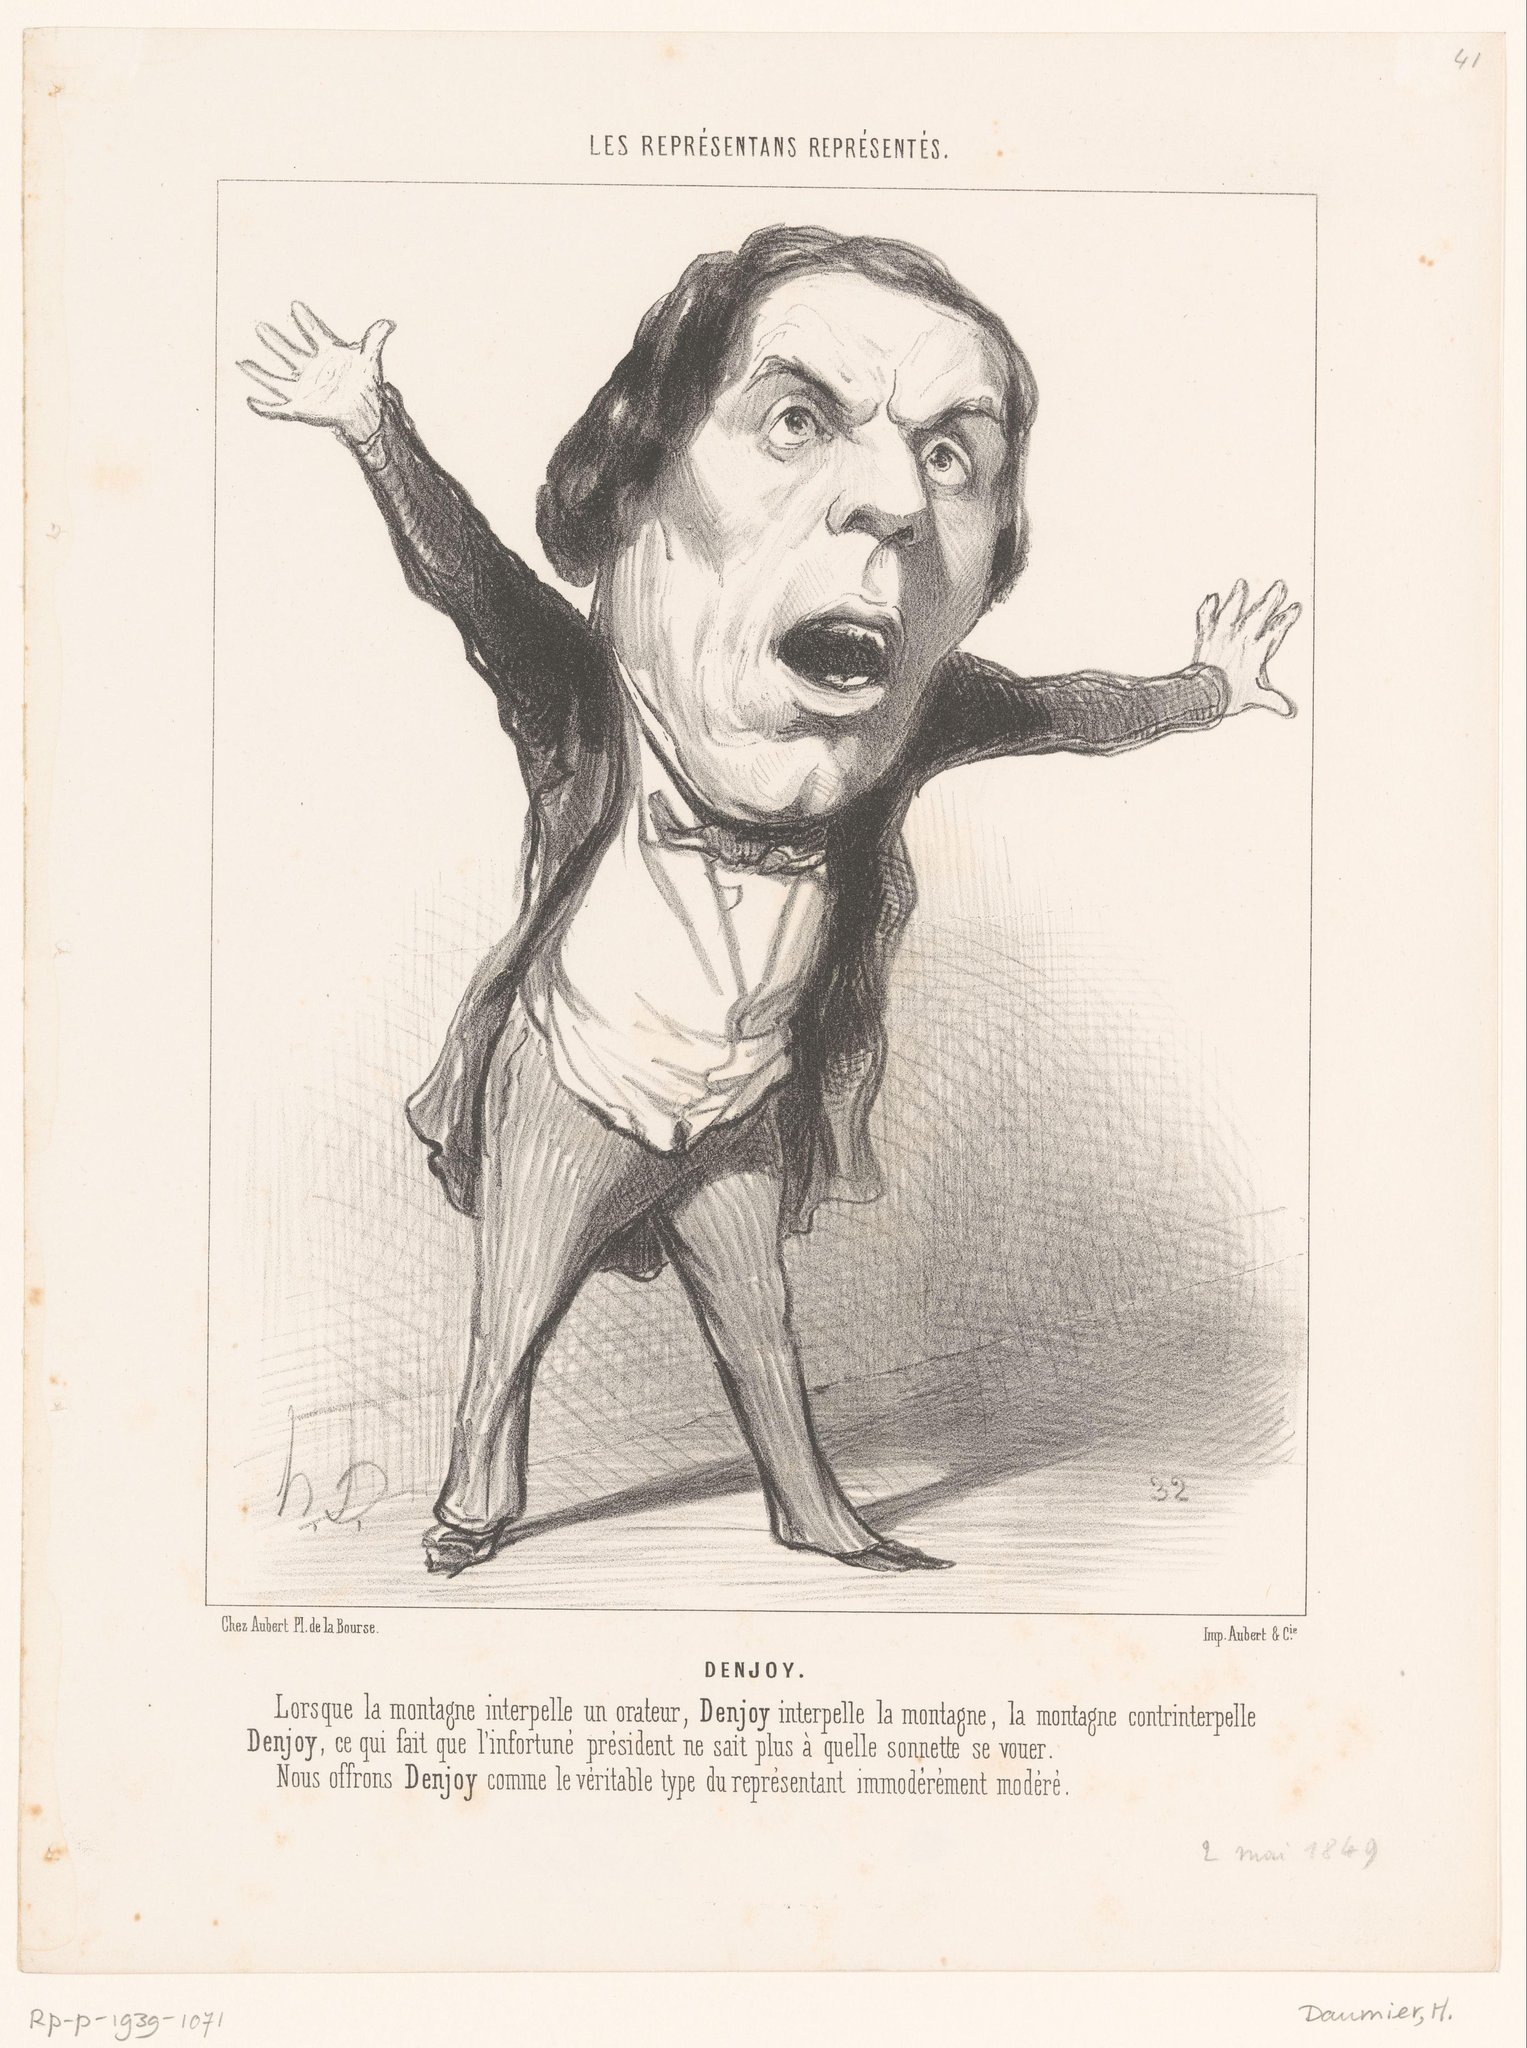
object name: cartoon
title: Denjoy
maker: honoré daumier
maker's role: draughtsman, painter, print maker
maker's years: 1808-1879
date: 1849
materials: paper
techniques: lithograph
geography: paris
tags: caricatures (human types), historical persons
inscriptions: collector's mark: Lugt 2166, collector's mark: Lugt 2760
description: Prent gebruikt voor: Le Charivari, 2 mei 1849.